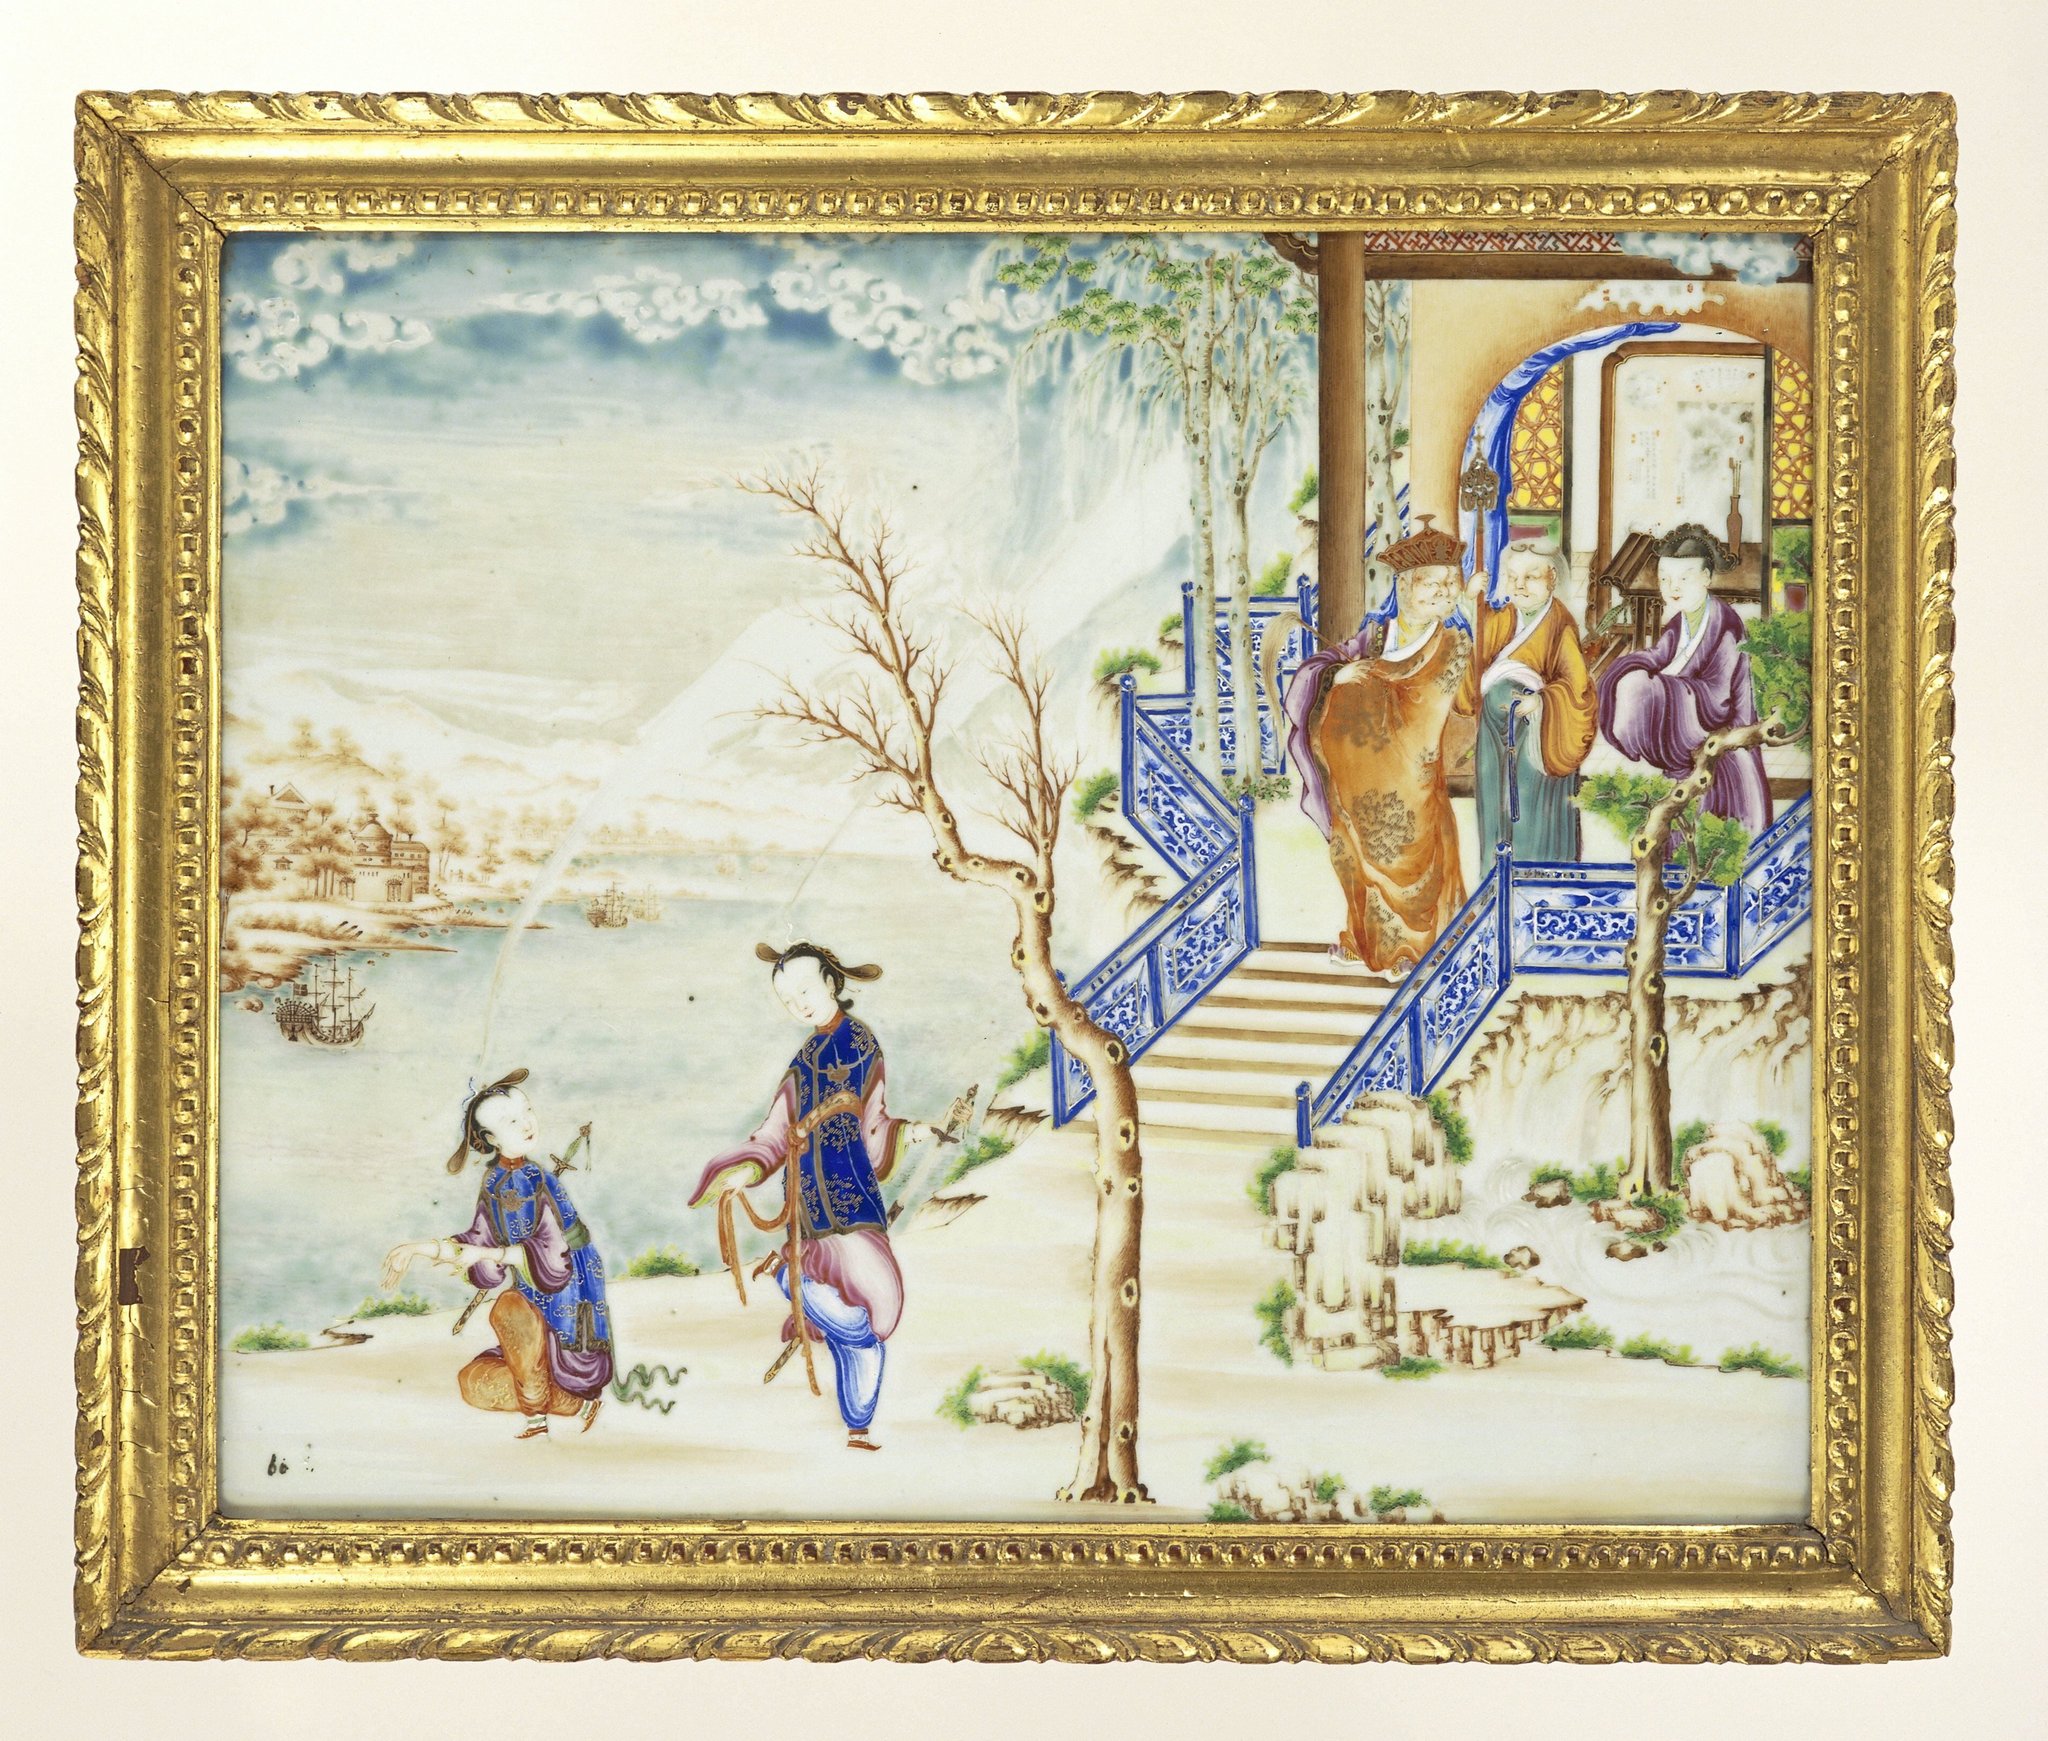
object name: plaque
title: Plaque depicting a scene from the Legend of the White Snake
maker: Anonymous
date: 1770-1775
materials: glaze, gold, paint, porcelain, wood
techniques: firing, forming, gilding, vitrification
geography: china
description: This scene is from the Legend of the White Snake. The thousand-year-old white snake Bai Suzhen transforms into a woman and falls in love with Xu Xian. However, the monk Fahai imprisons Xu in his temple. Here, at the lower left, Bai and her maidservant Xiaoqing are about to use their magical powers to flood the temple in order to rescue Xu.